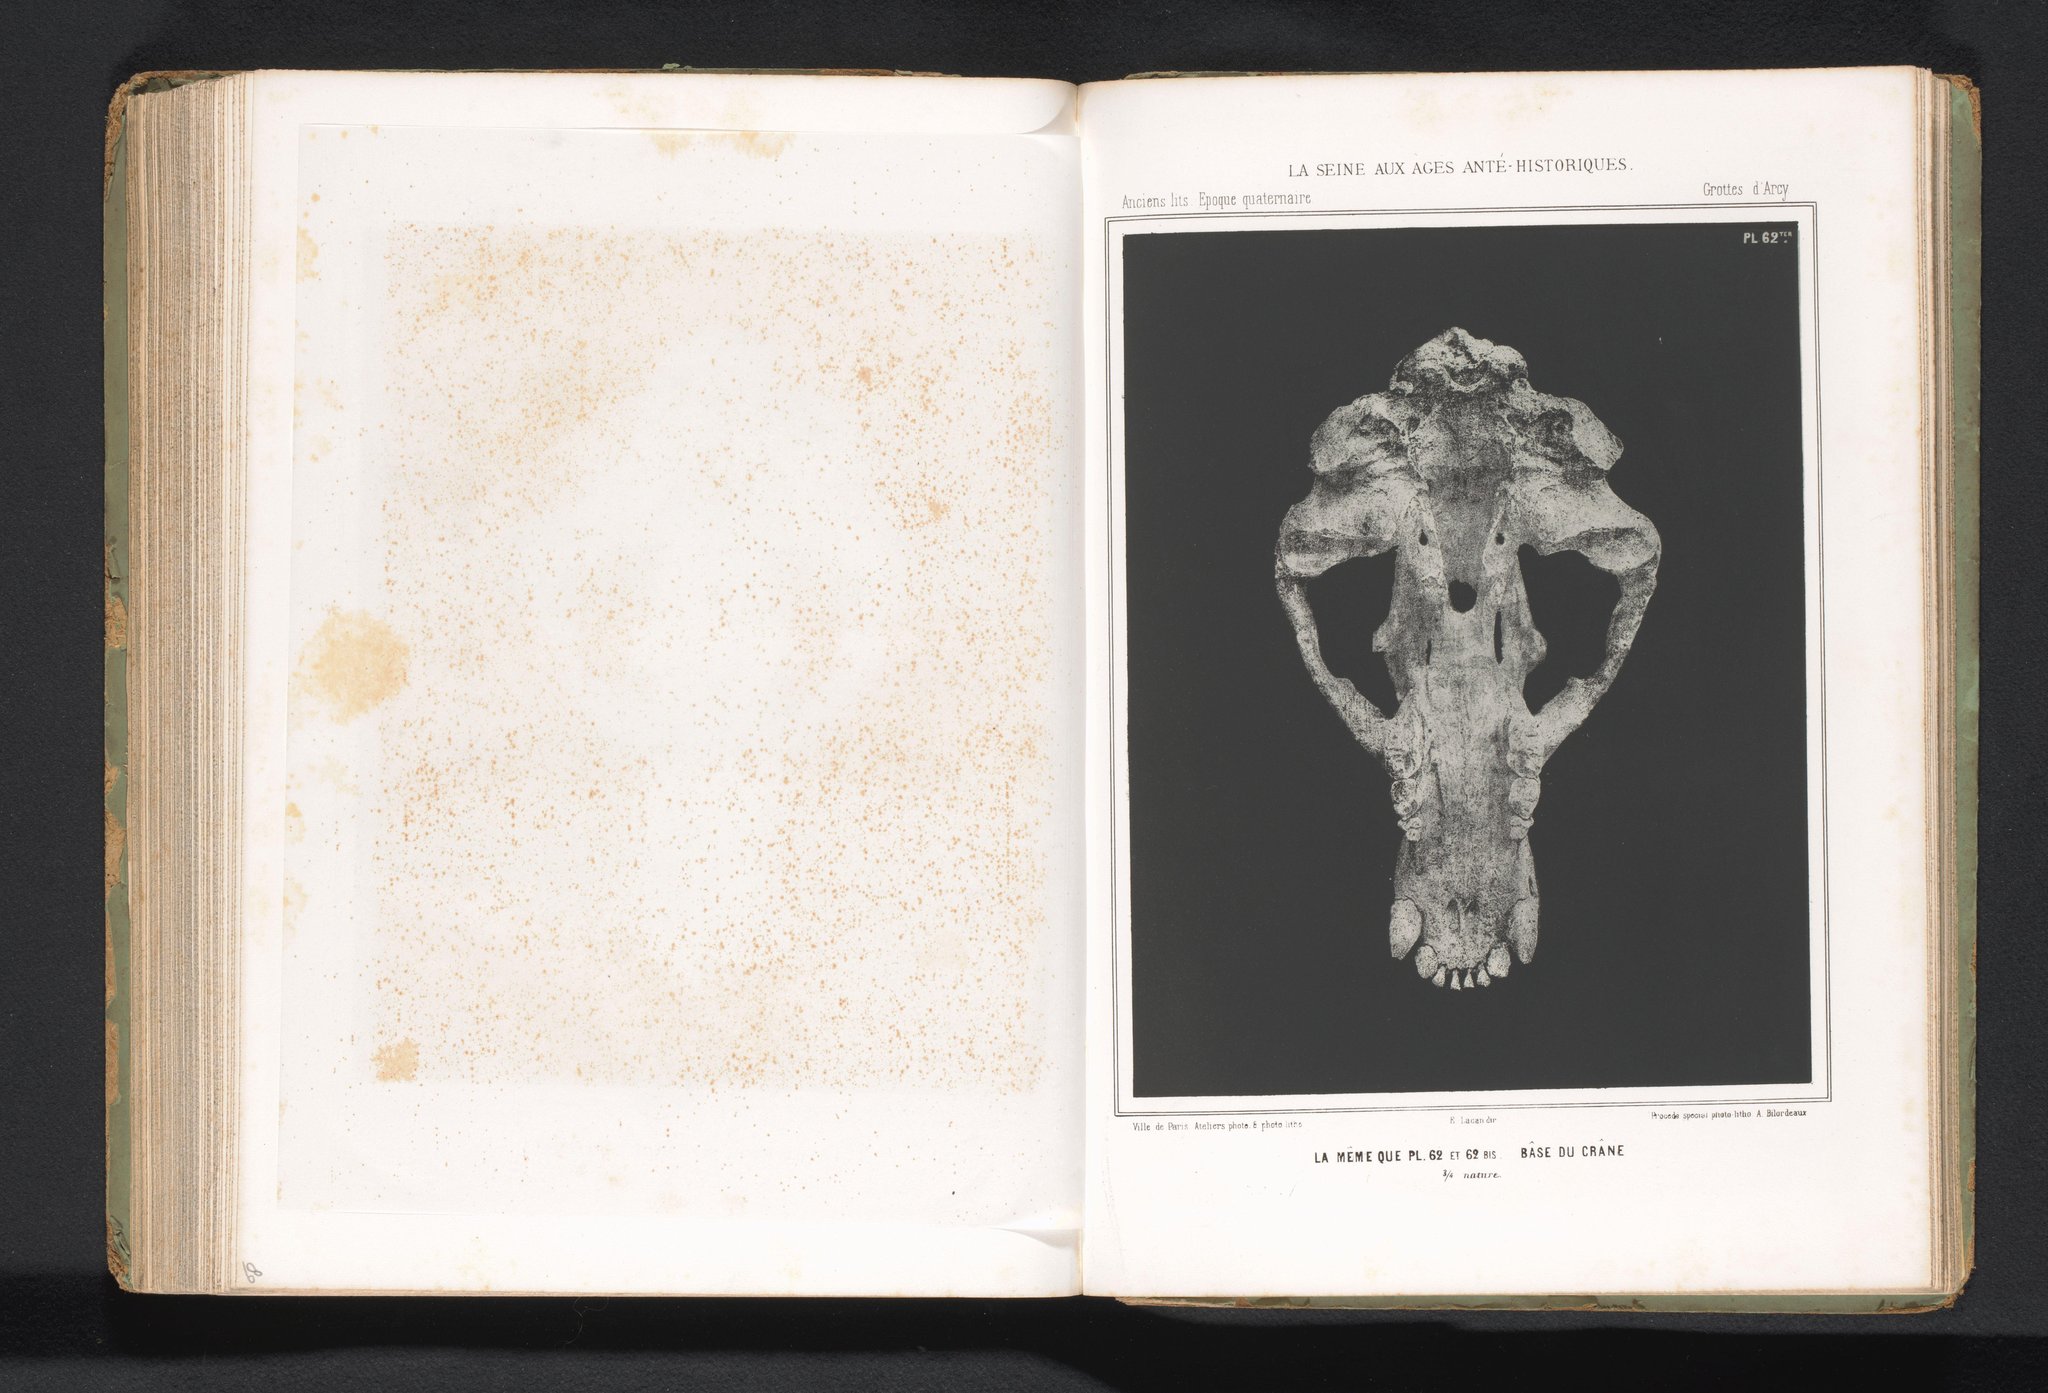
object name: photomechanical print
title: Schedel van een holenbeer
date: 1864-1869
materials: paper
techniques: photolithography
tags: mammals (+ skeleton of an animal)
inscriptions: inscription: ‘Procédé spécial photo-lithographique’, inscription: ‘3/4 nature’, inscription: ‘LA MÊME QUE PL. 62 ET 62 BIS BASE DU CRANE’, inscription: ‘PL.62 ter’